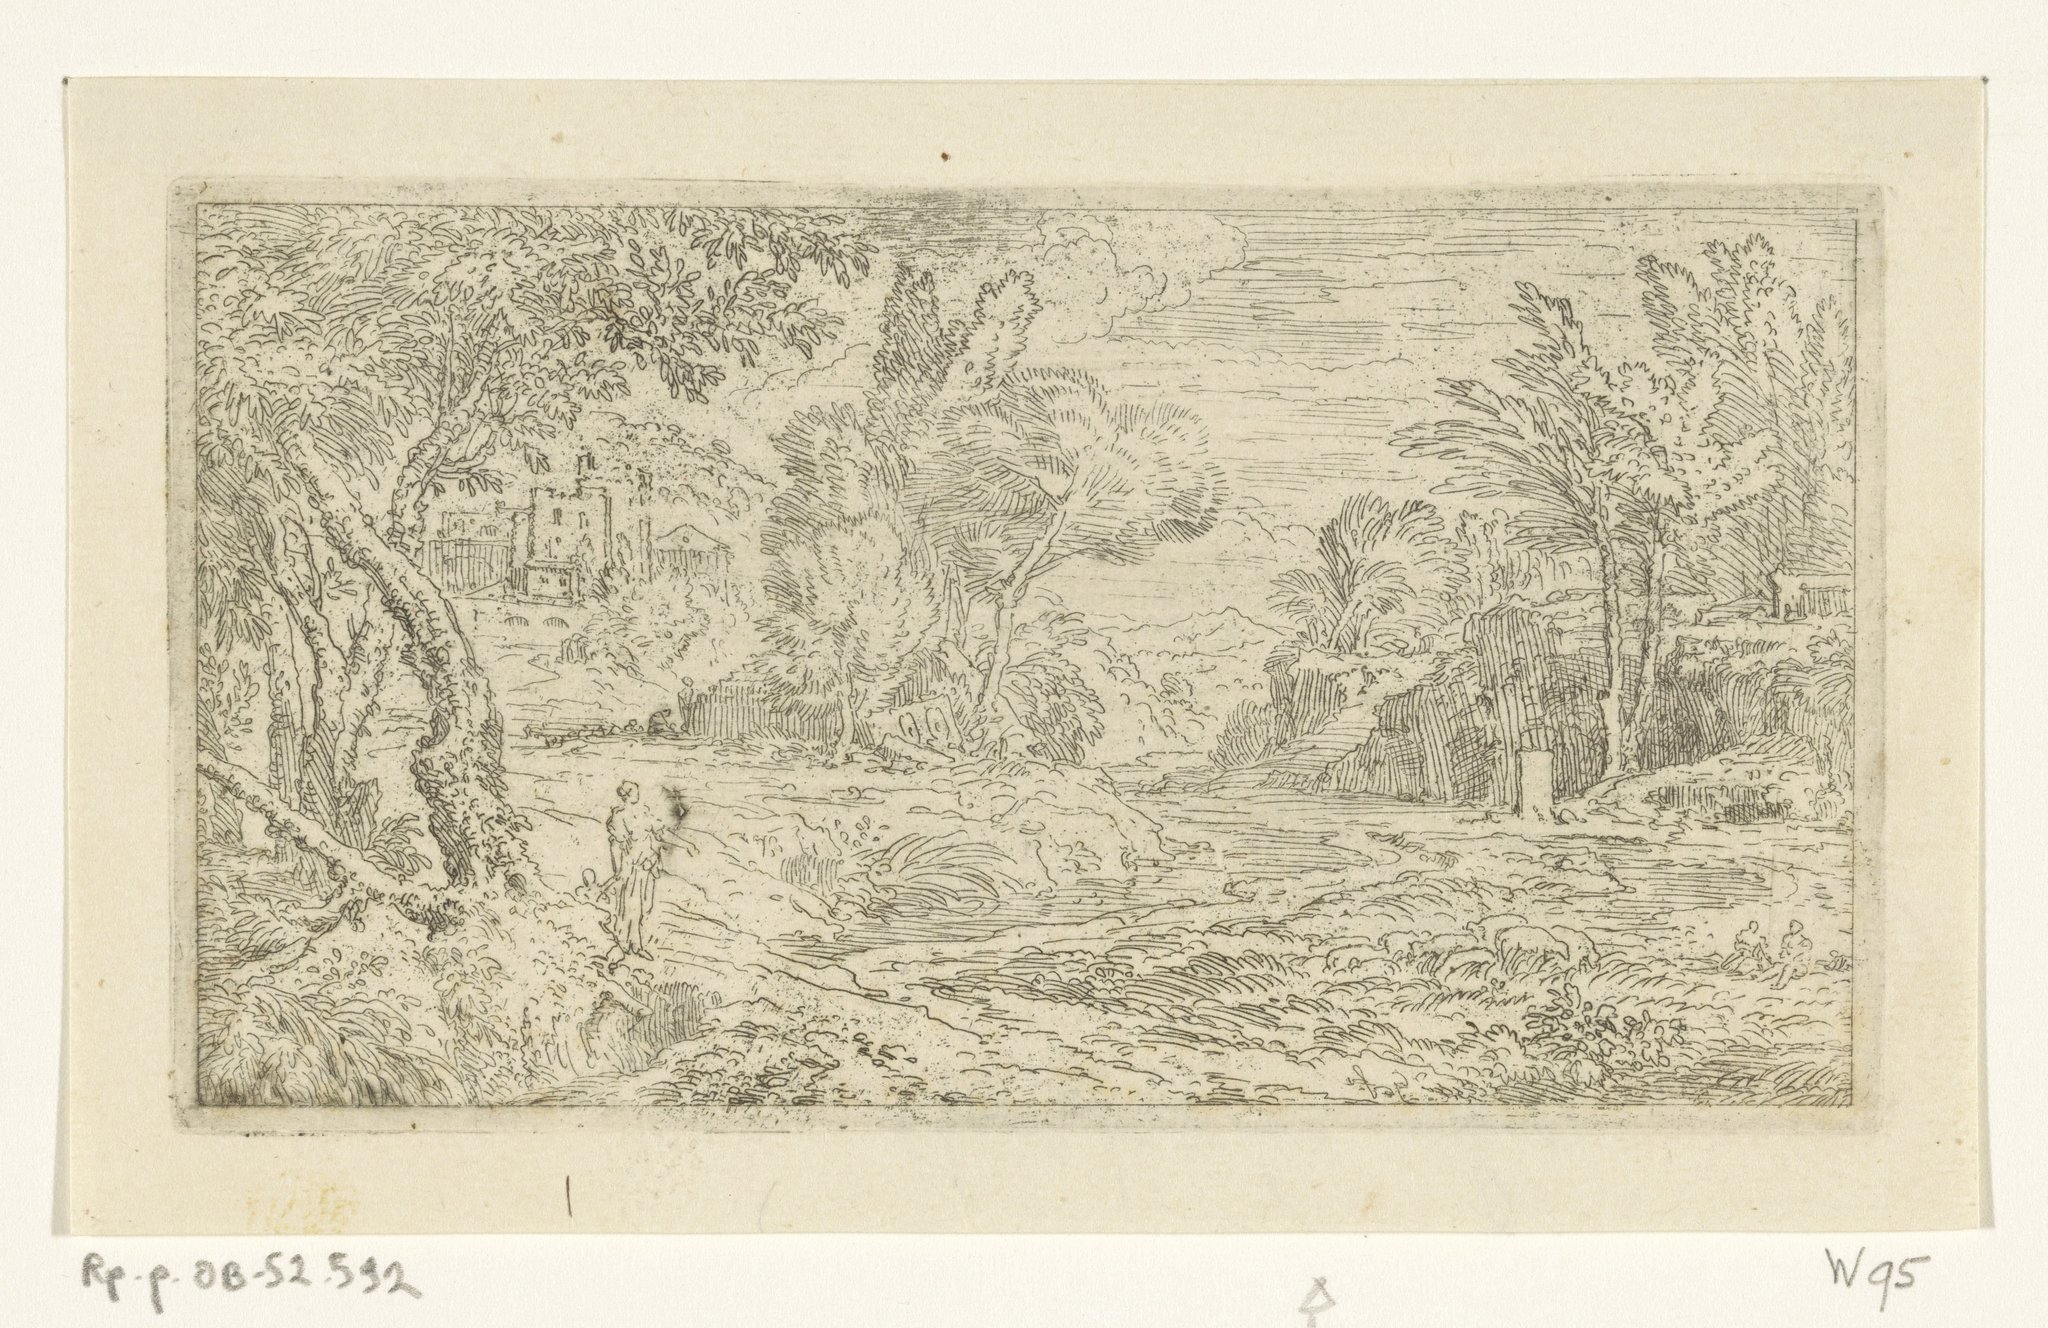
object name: print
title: Landschap met rivier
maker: abraham genoels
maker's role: draughtsman, print maker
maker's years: 1640-1723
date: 1650-1723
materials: paper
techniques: etching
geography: paris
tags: mother and baby or young child, river (+ landscape with figures, staffage)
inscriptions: collector's mark: Lugt 240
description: Een landschap met een rivier. Op de voorgrond links een vrouw met kind. Op de achtergrond een stad.